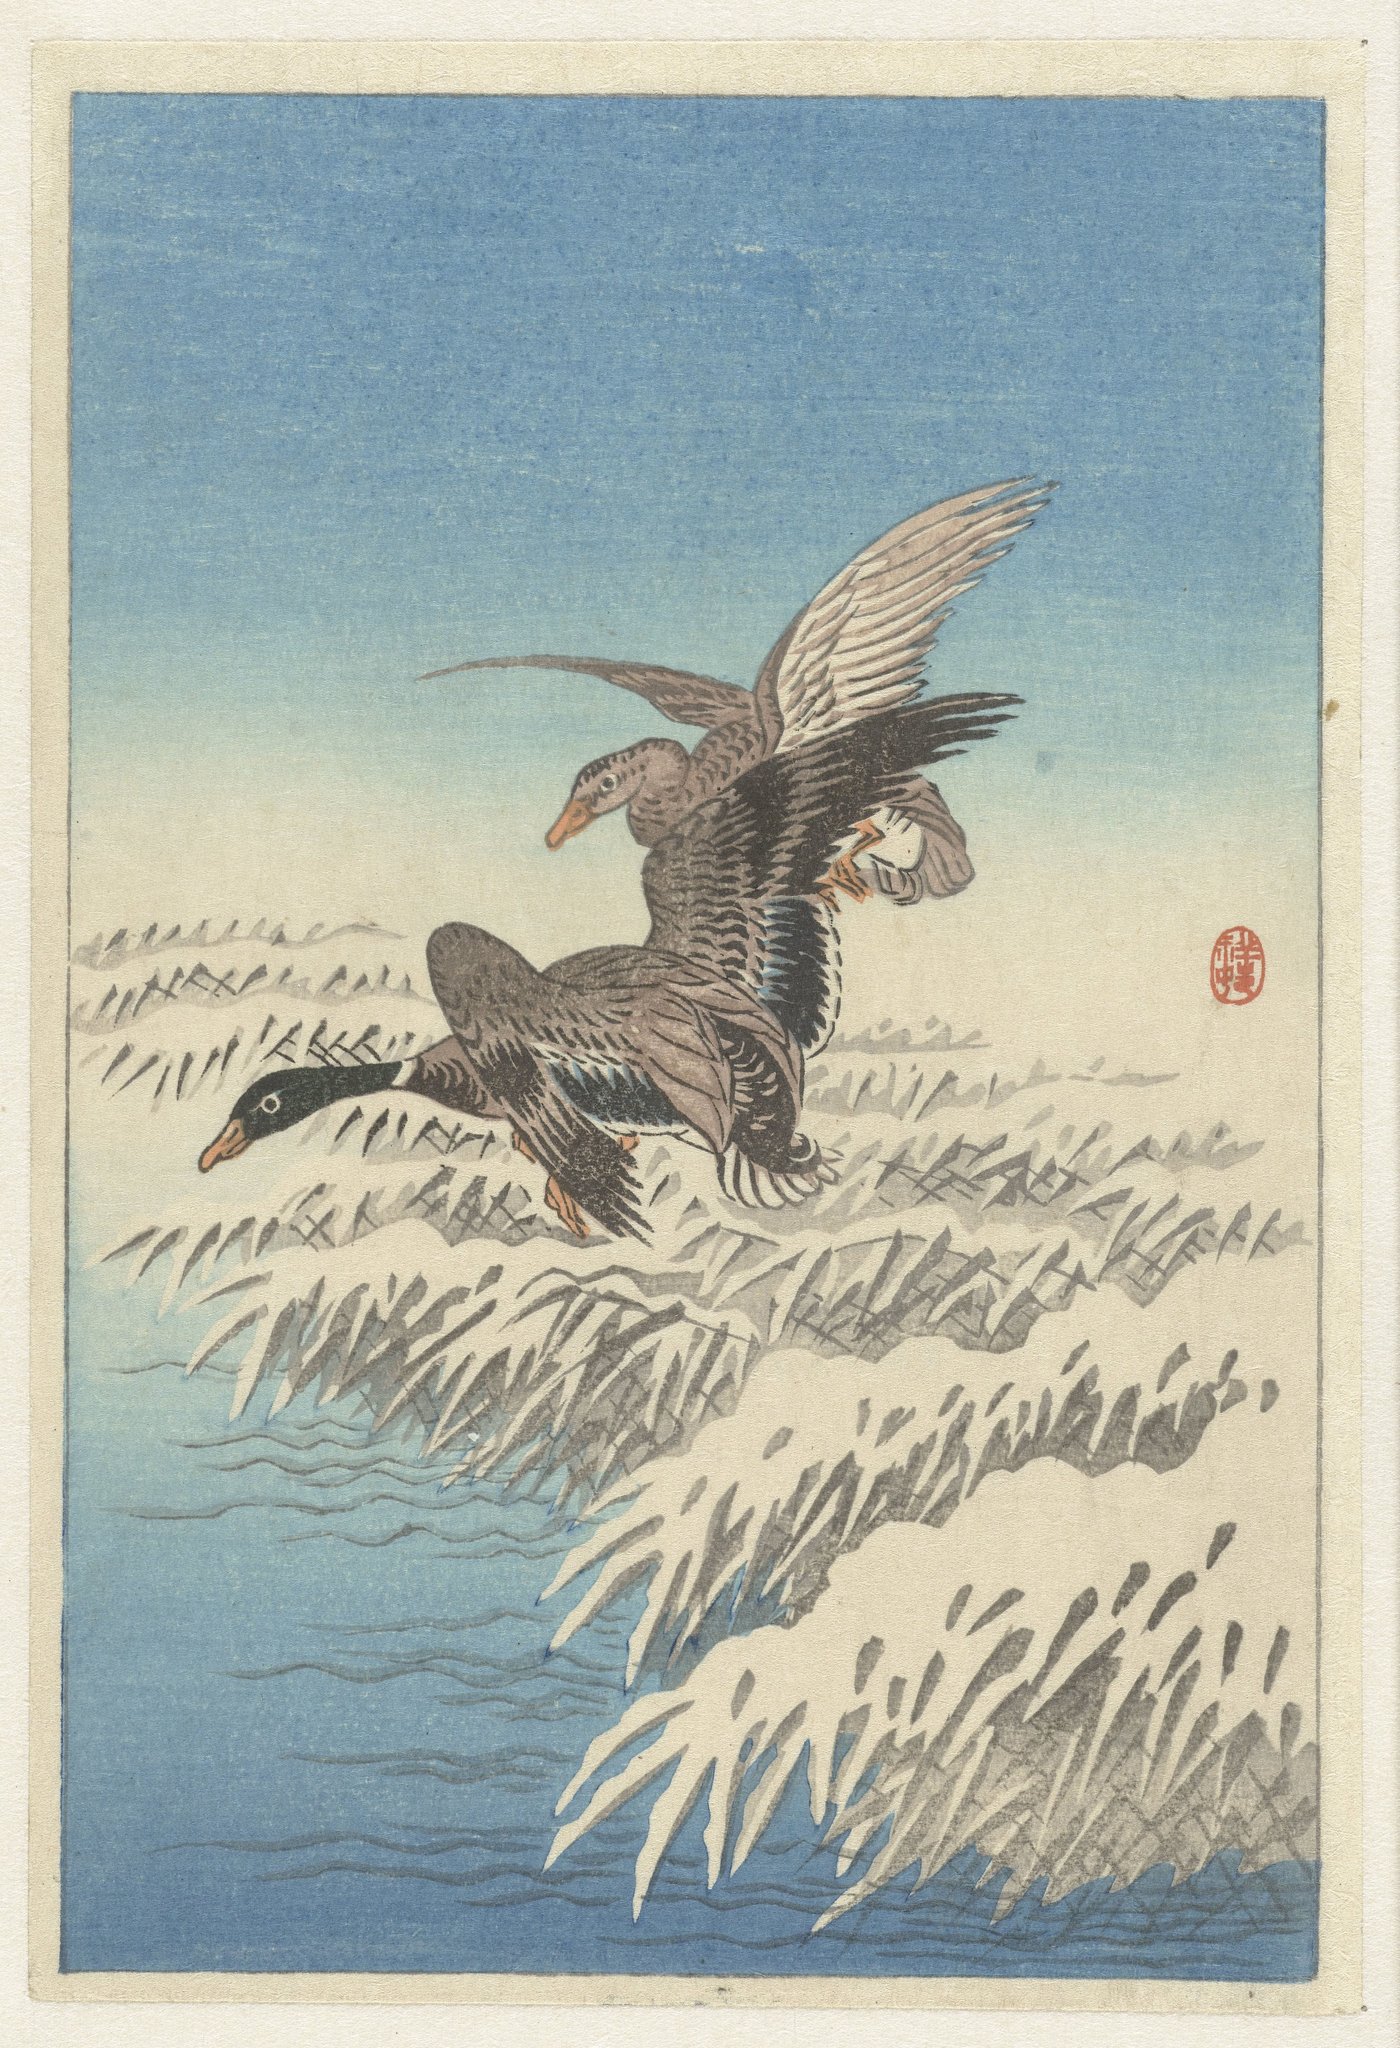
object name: print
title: Koppel eenden vliegend boven besneeuwde rietkraag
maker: ohara koson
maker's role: print maker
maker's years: 1877-1945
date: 1900-1945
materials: paper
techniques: woodcut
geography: tokyo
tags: flying, snow, water-birds: duck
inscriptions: collector's mark: Lugt 2228